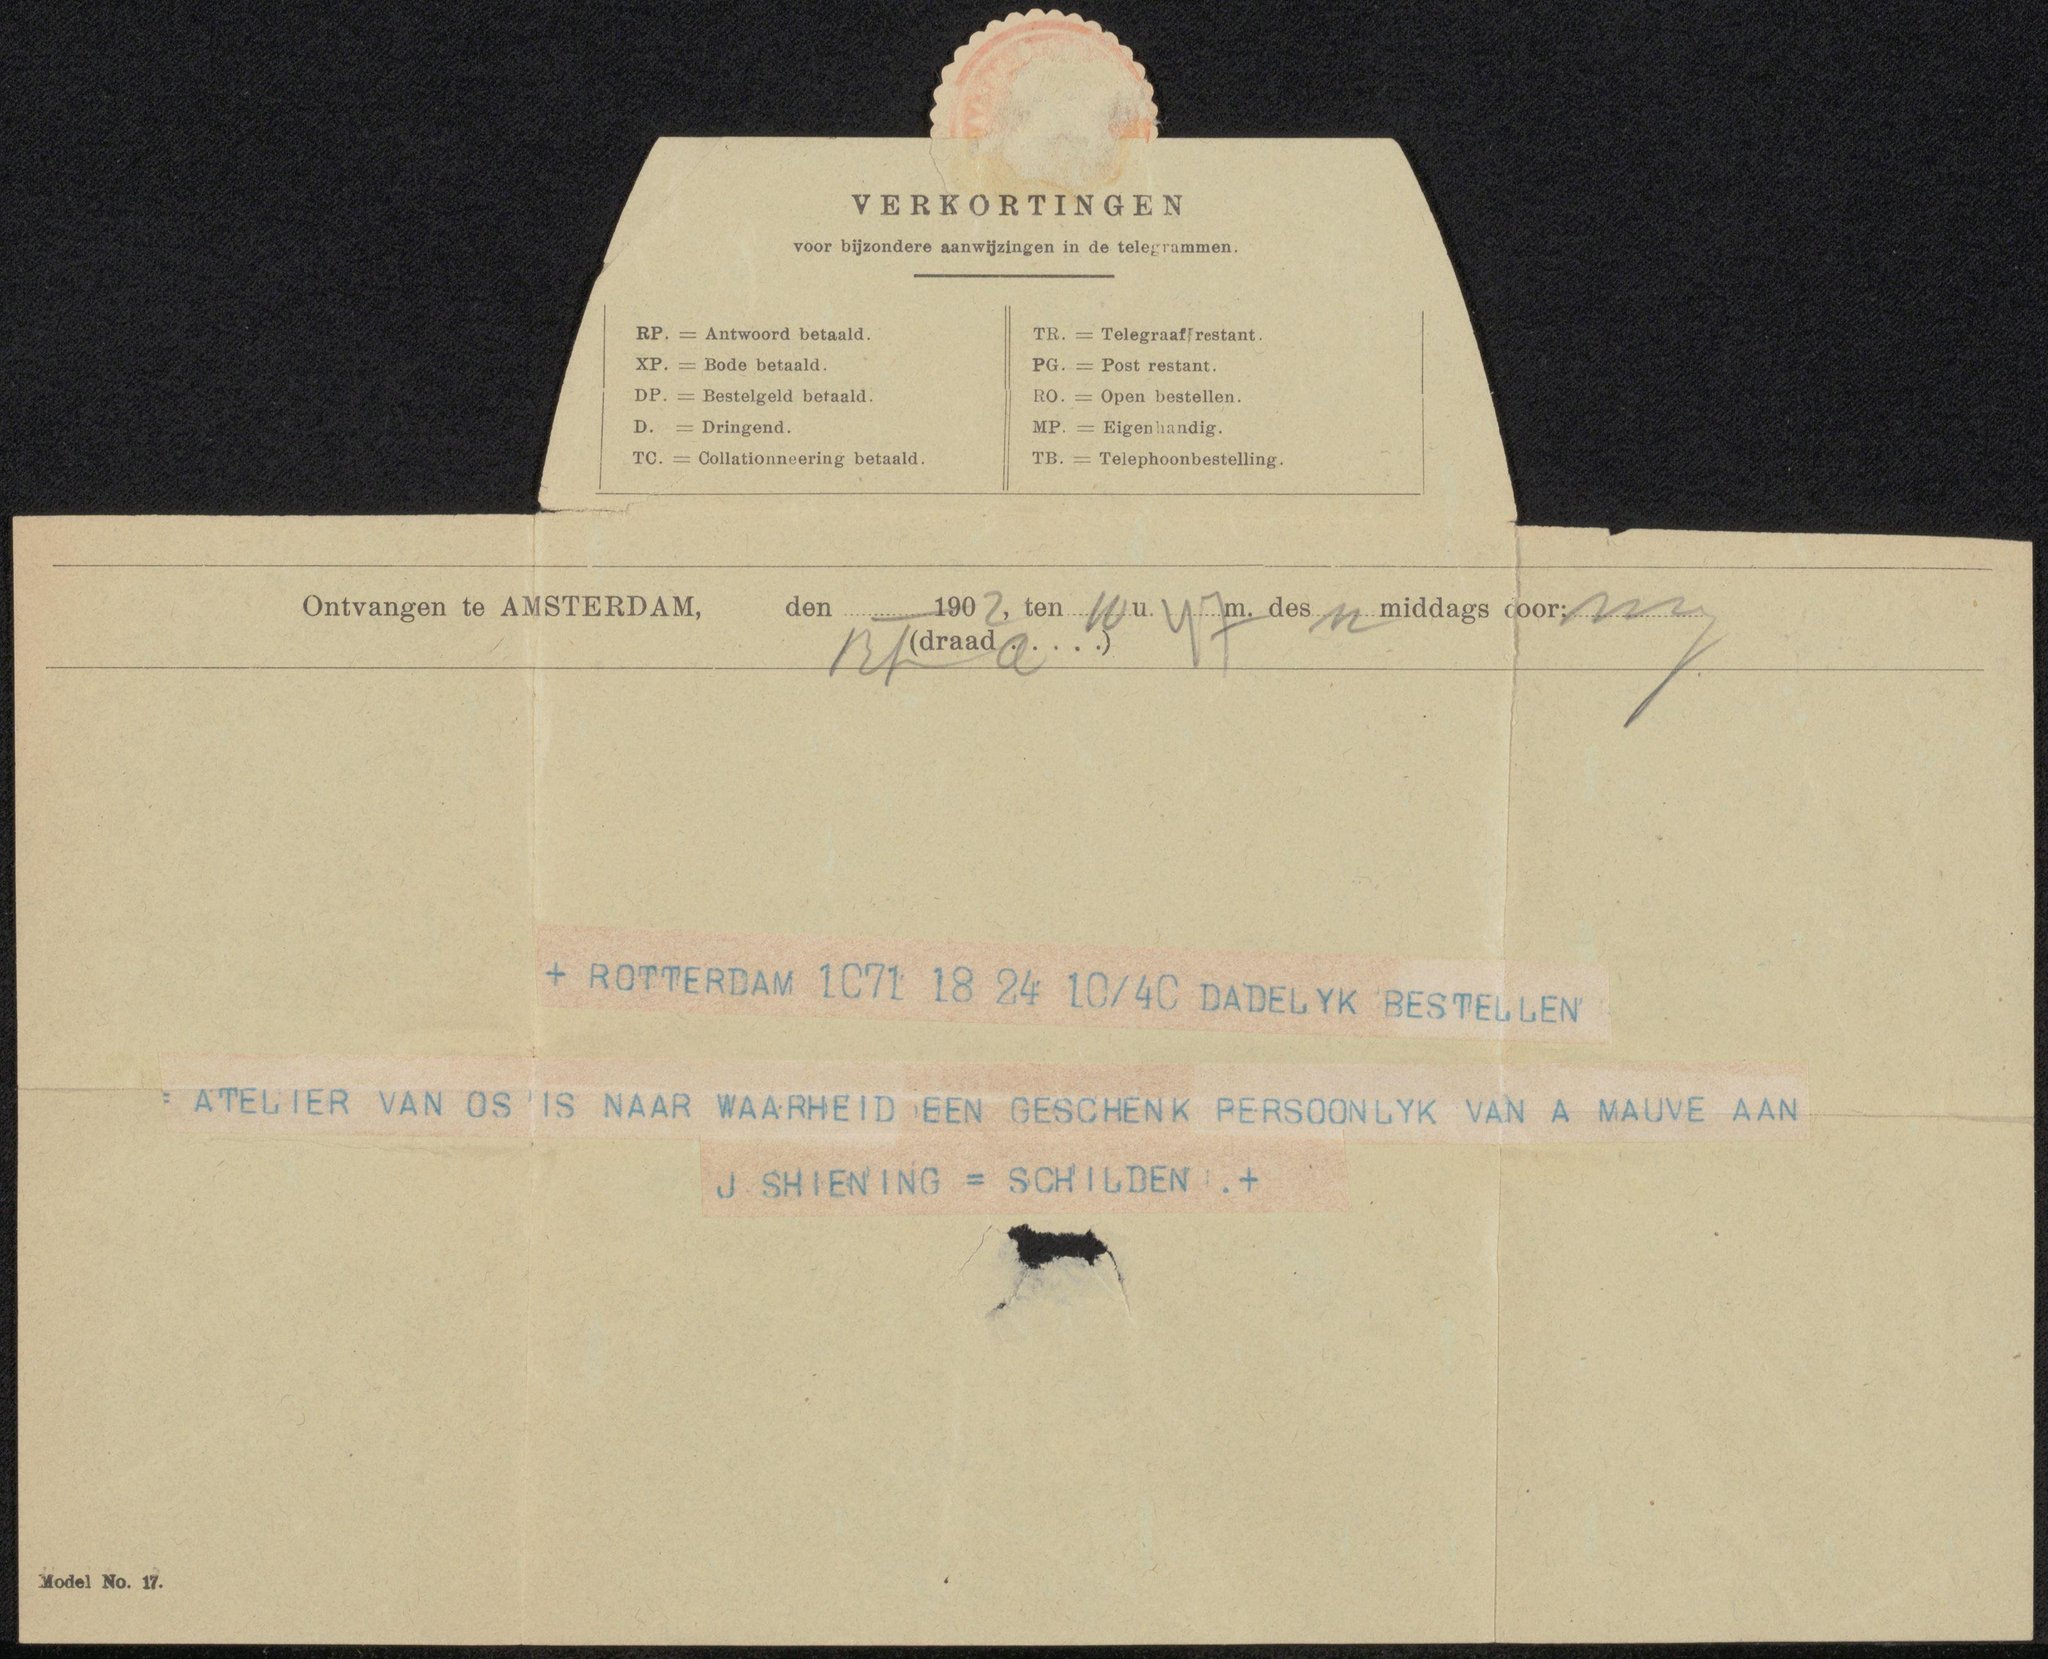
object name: telegram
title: Telegram aan Frederik Muller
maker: Anonymous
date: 1902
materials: ink, paper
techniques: pen, printing, typewriting, writing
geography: rotterdam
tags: haarlem, pieter frederik van os, arnhem, painter, print maker, draughtsman, anton mauve, jan striening, bookseller, frederik muller, painting (including book-illumination, miniature-painting)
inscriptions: collector's mark: ‘RPK’, seal